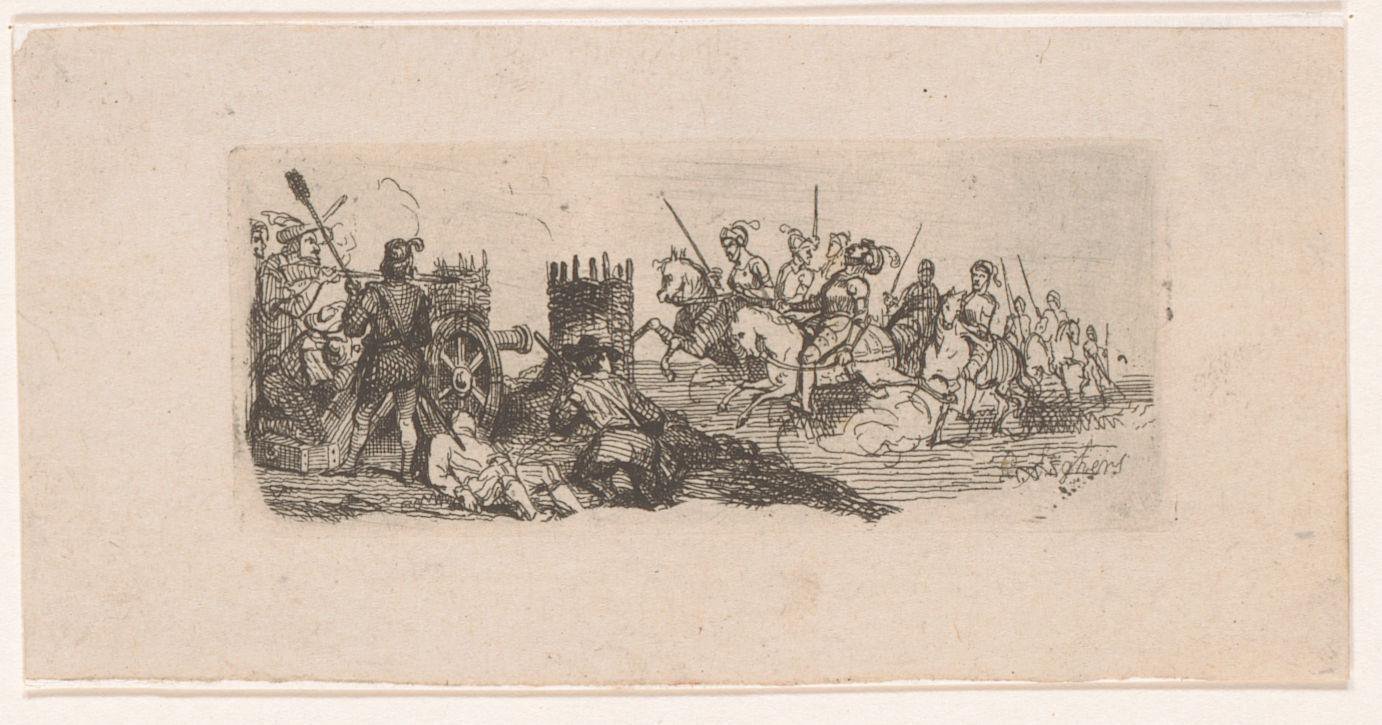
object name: print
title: Ridders te paard bestormen schanskorven bij een kanon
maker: corneille seghers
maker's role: draughtsman, print maker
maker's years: 1814-1869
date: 1824-1869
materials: paper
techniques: etching, intaglio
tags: firearms: cannon, knight, temporary fortifications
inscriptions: collector's mark: Lugt 1485, collector's mark: Lugt 2228